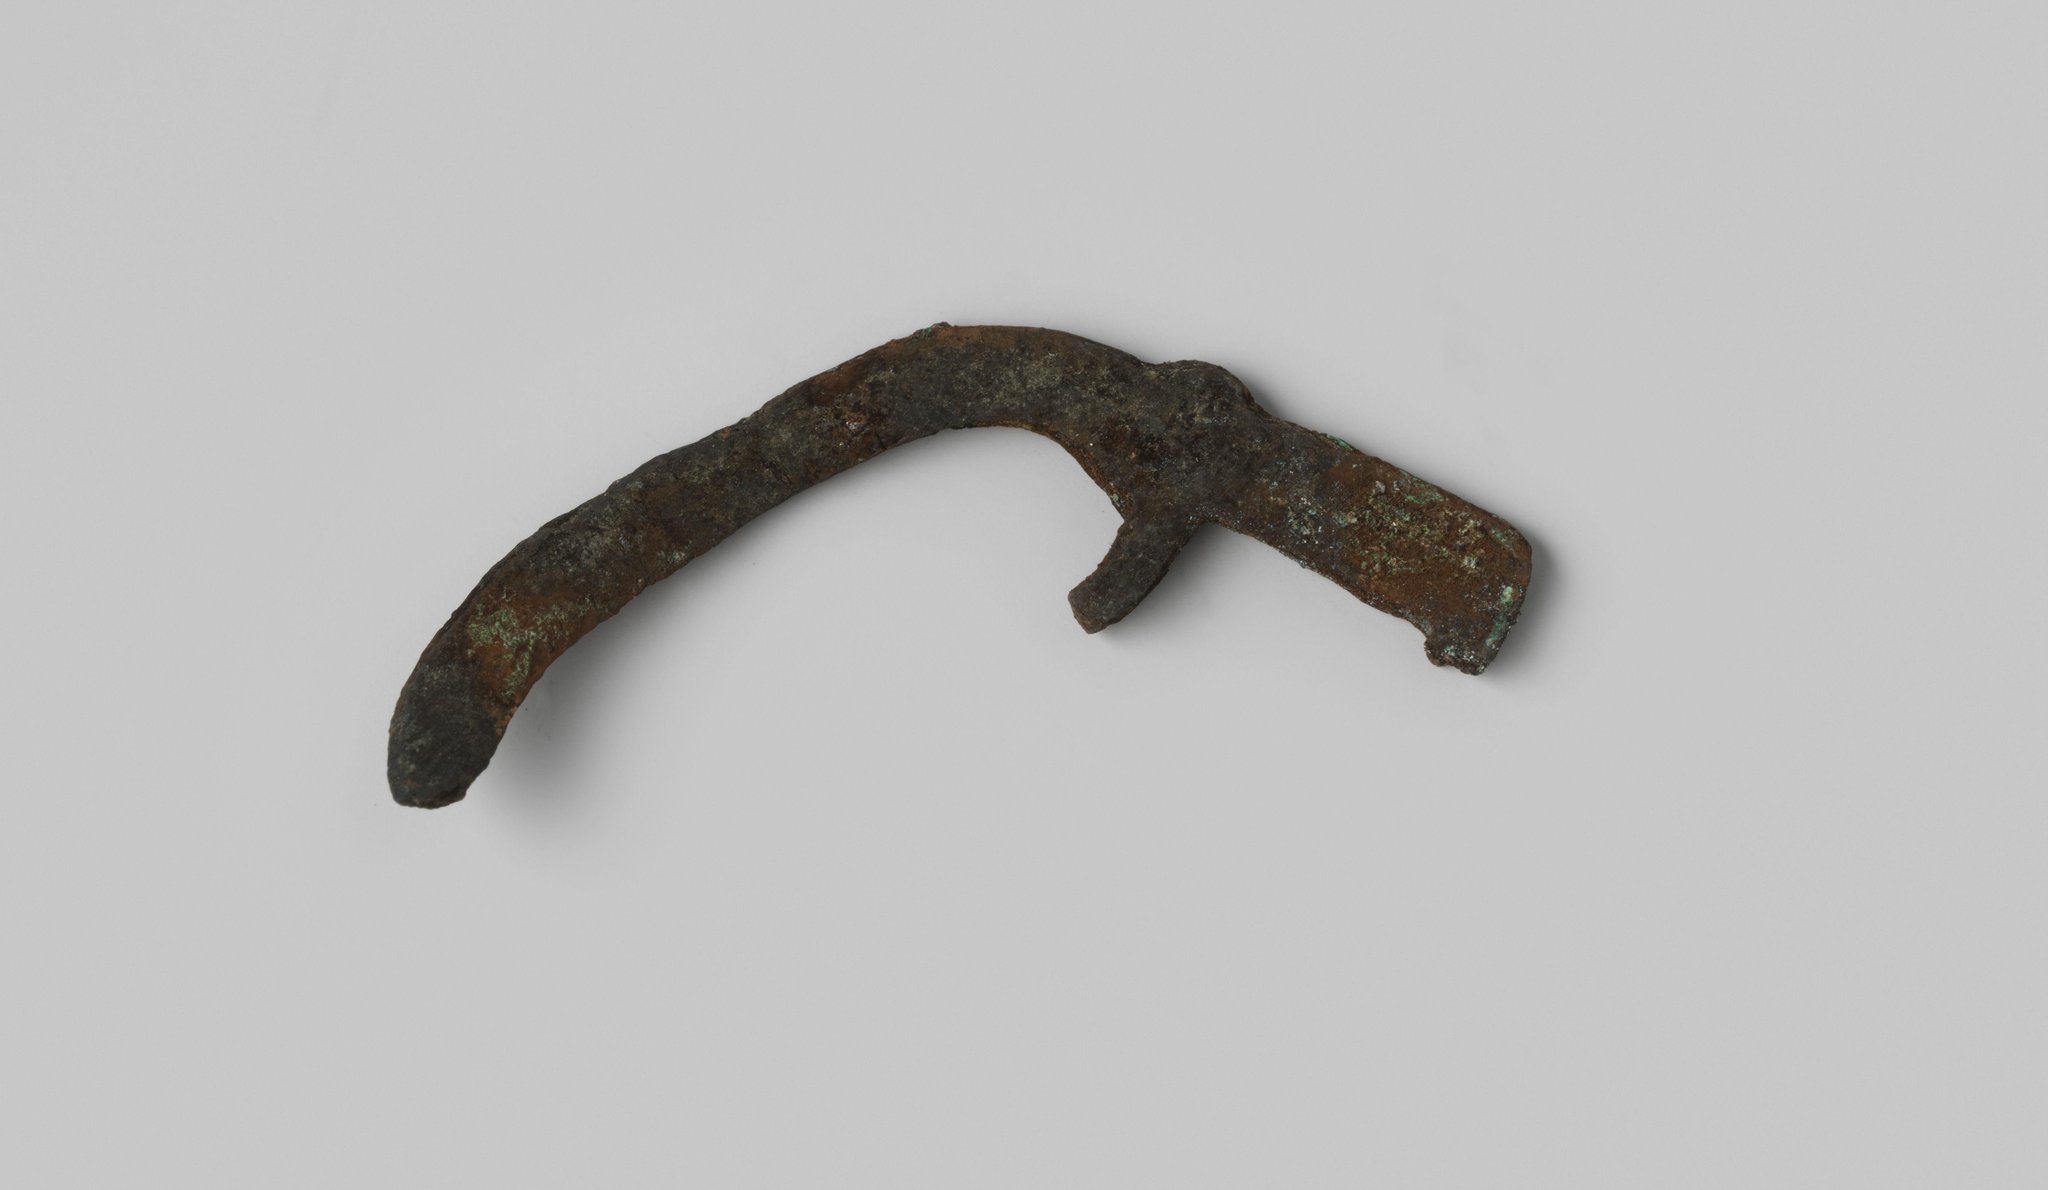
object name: belt buckle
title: Fragment riemgesp uit het wrak van de Oost-Indiëvaarder Hollandia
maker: Anonymous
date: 1700-1743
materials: copper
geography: netherlands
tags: verenigde oostindische compagnie, hollandia (schip), annet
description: D-shaped, fragm of ring, id. NG 1979-182H2177, belt buckle.